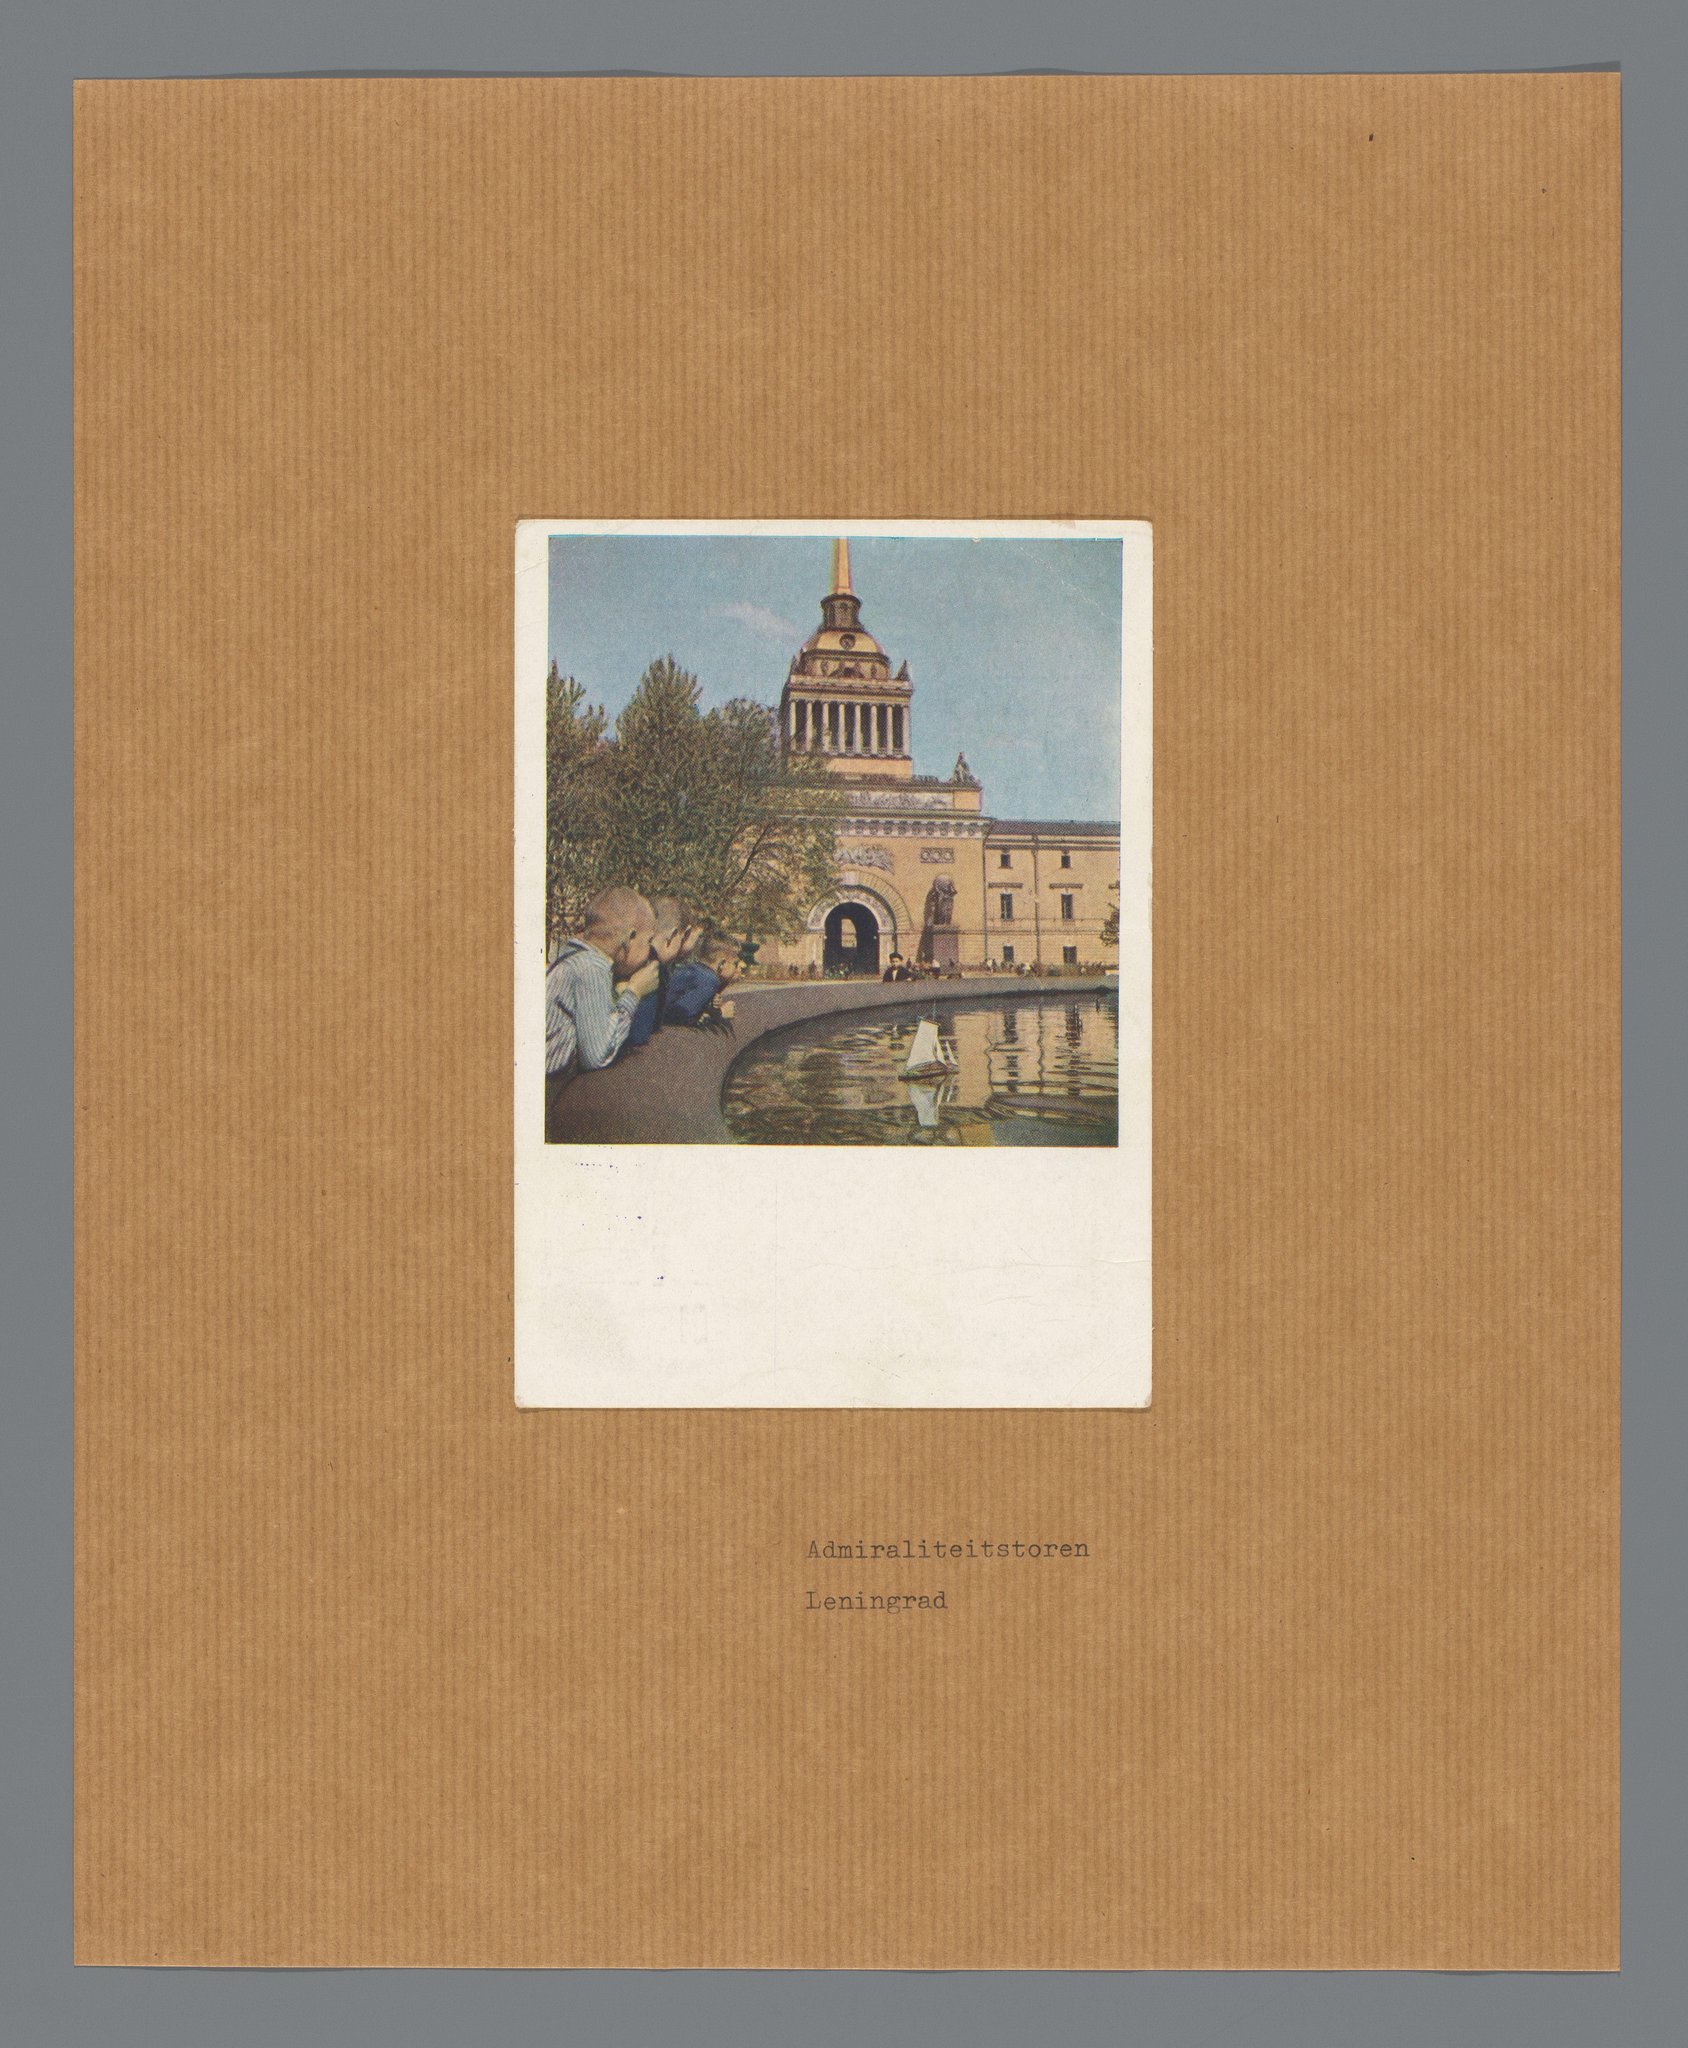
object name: photograph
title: Admiraliteitstoren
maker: Anonymous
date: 1902-1950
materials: photographic support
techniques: offset printed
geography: russia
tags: russia